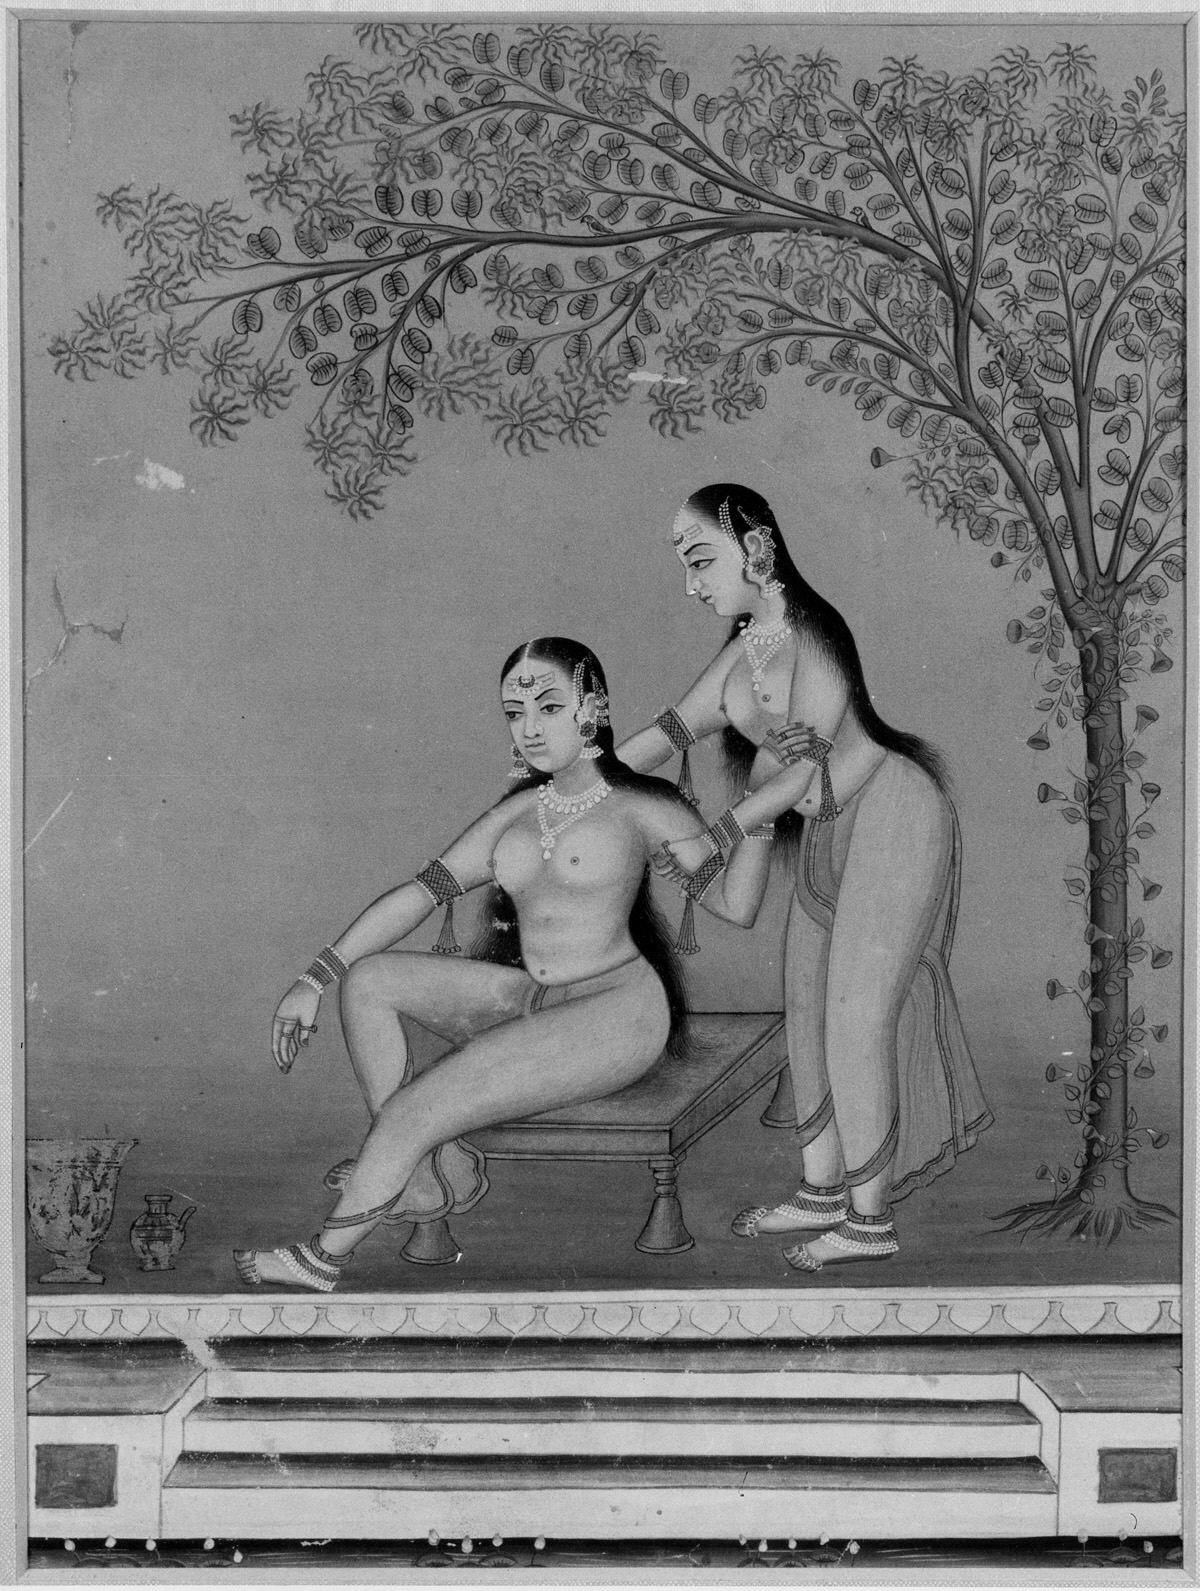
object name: painting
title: Lady at Her Toilette with Attendant on a Terrace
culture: indian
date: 1800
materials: gold, paper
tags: women,female nudes